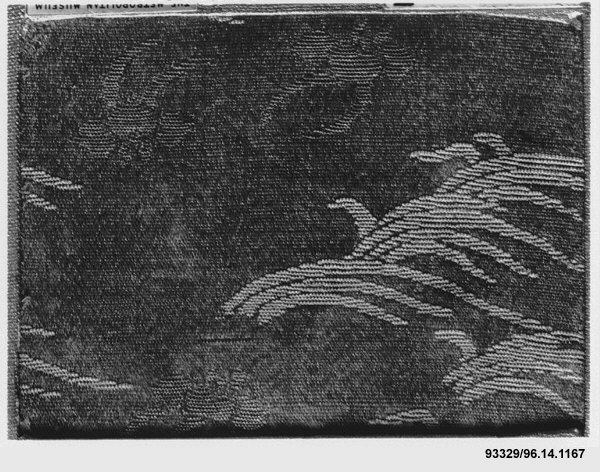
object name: piece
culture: japanese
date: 1701-1900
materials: silk